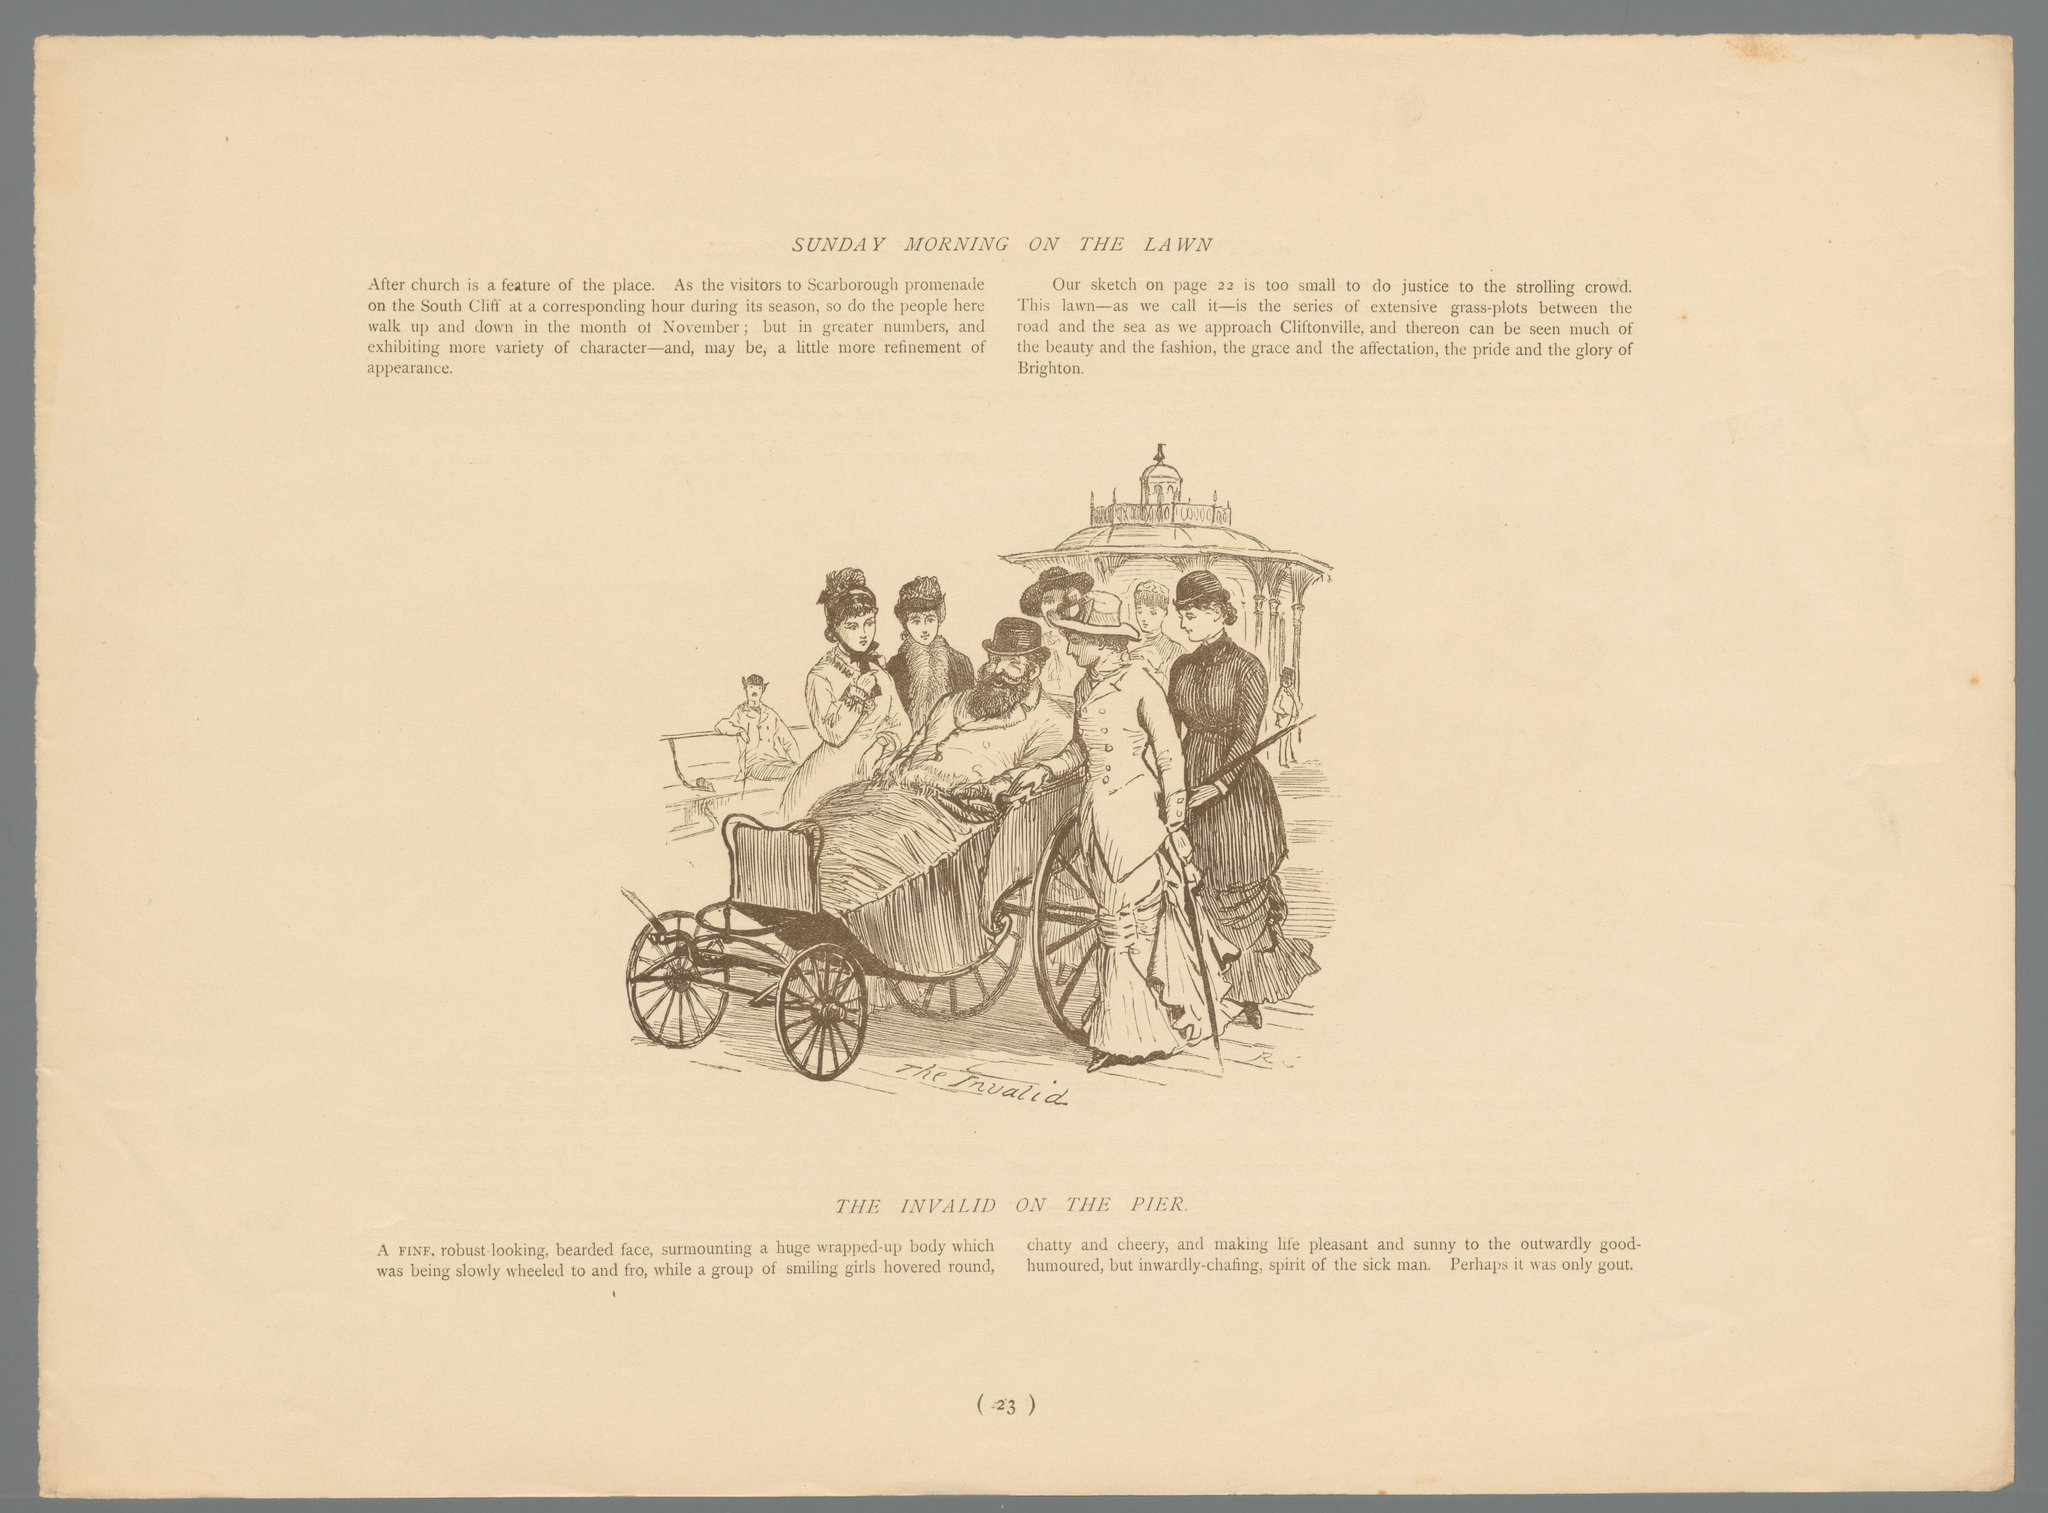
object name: print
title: The invalid on the pier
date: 1889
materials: paper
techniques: letterpress printing, engraving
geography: london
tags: patient, sick person, street (+ city(-scape) with figures, staffage)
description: Prent uit: Gleanings from the Graphic. Londen: George Routledge & Sons, 1889. Dit werk is een bundel van diverse illustraties die eerder verschenen in verschillende jaargangen van het Engelse weekblad 'The Graphic'. De bundel is na het overlijden van Randolph Caldecott uitgegeven.